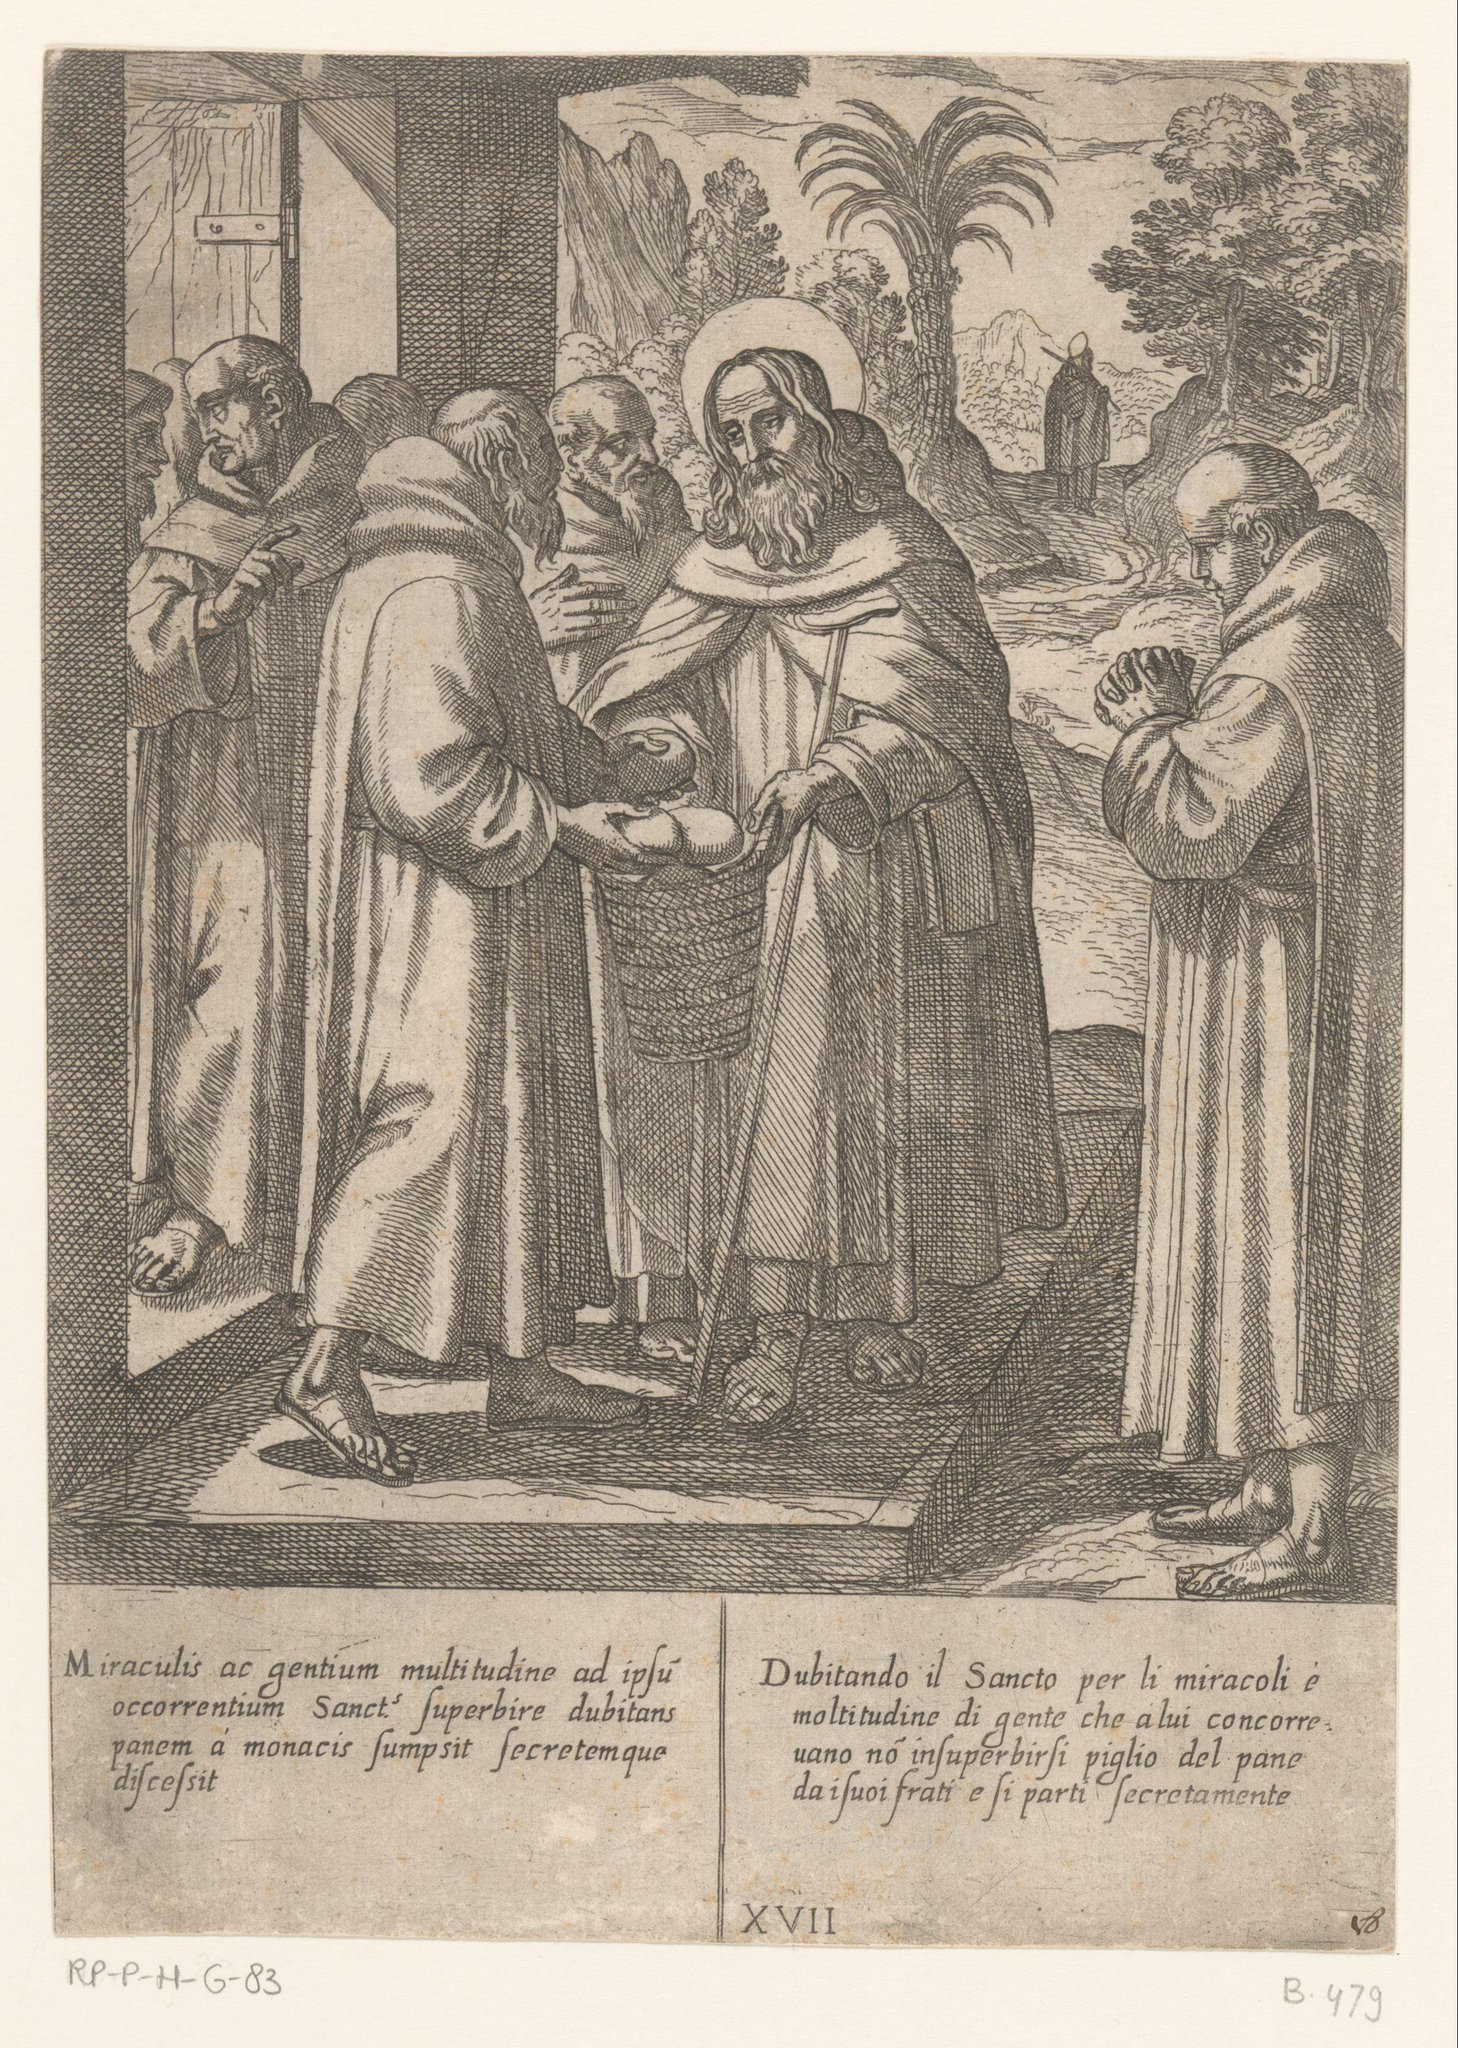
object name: print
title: Het leven van de heilige Antonius de Grote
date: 1598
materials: paper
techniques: etching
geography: italy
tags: the hermit antony abbot (antonius abbas) of egypt, also called the great; possible attributes: bell, book, t-shaped staff, flames, pig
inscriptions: collector's mark: ‘Hinloopen’, collector's mark: Lugt 11, number: ‘18’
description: Deze prent maakt deel uit van een reeks van 27 prenten (+ titelprent) over het leven van de heilige Antonius, naar een frescocyclus in de S. Antonio Abbate in Rome door Giovanni Battista Lombardelli en Niccolò Circignani.